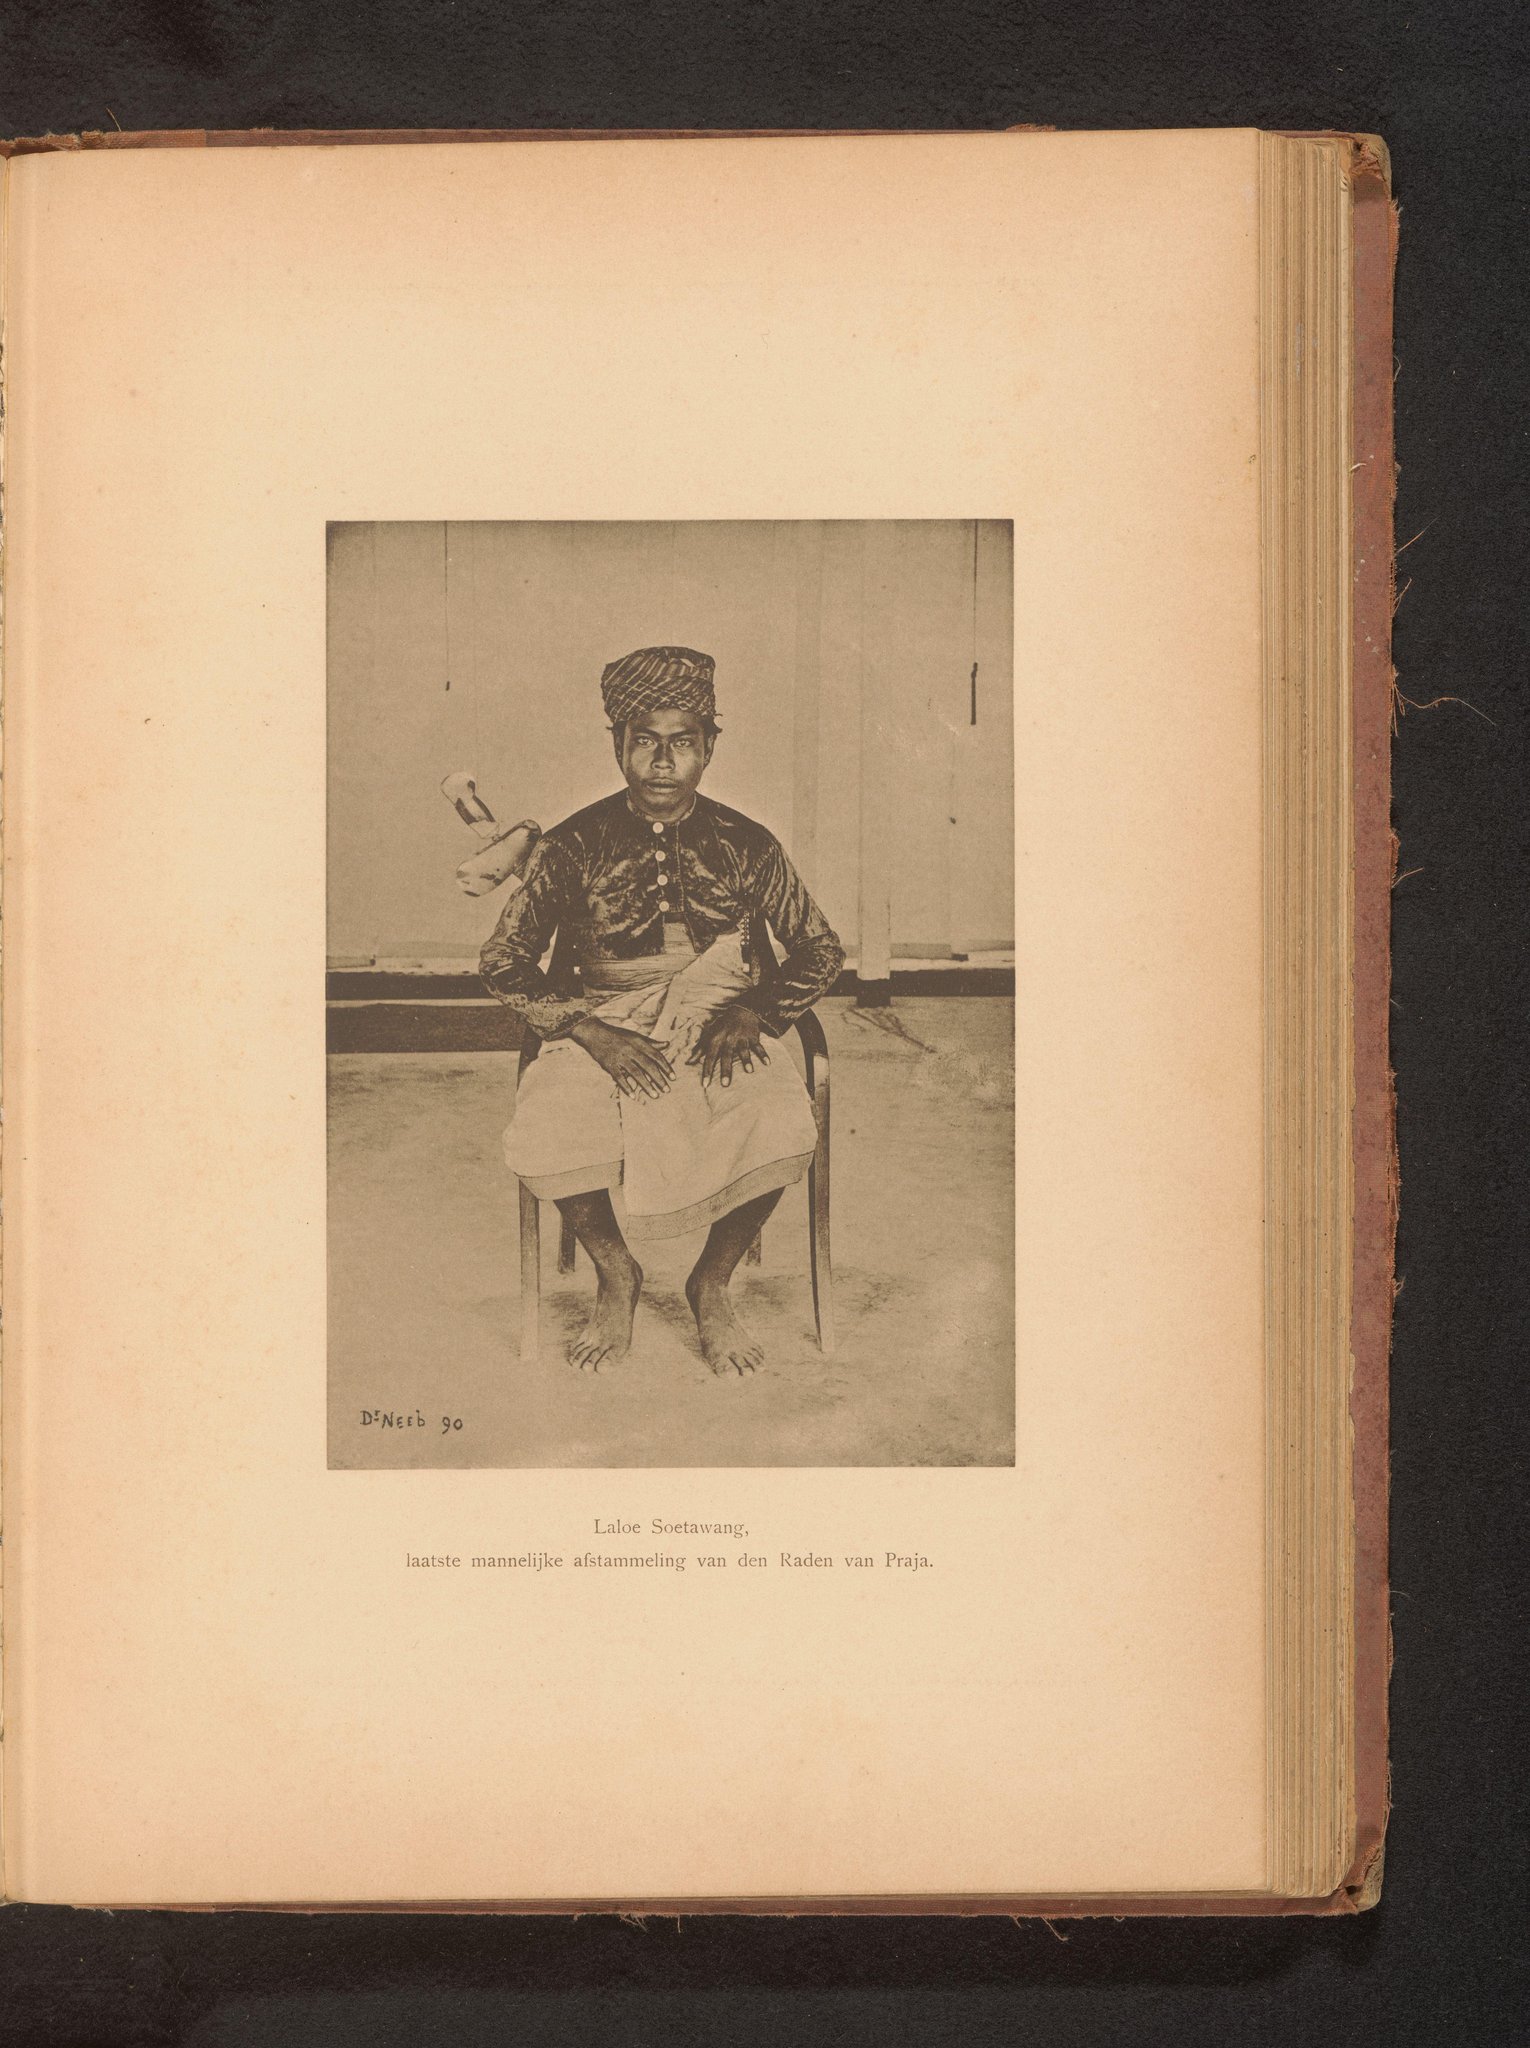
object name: photomechanical print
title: Portret van Laloe Soetawang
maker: christiaan johan neeb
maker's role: arts, fotograaf, officier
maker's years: 1860-1925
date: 1892-1897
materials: paper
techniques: photograph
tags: adult man, historical persons, indonesia